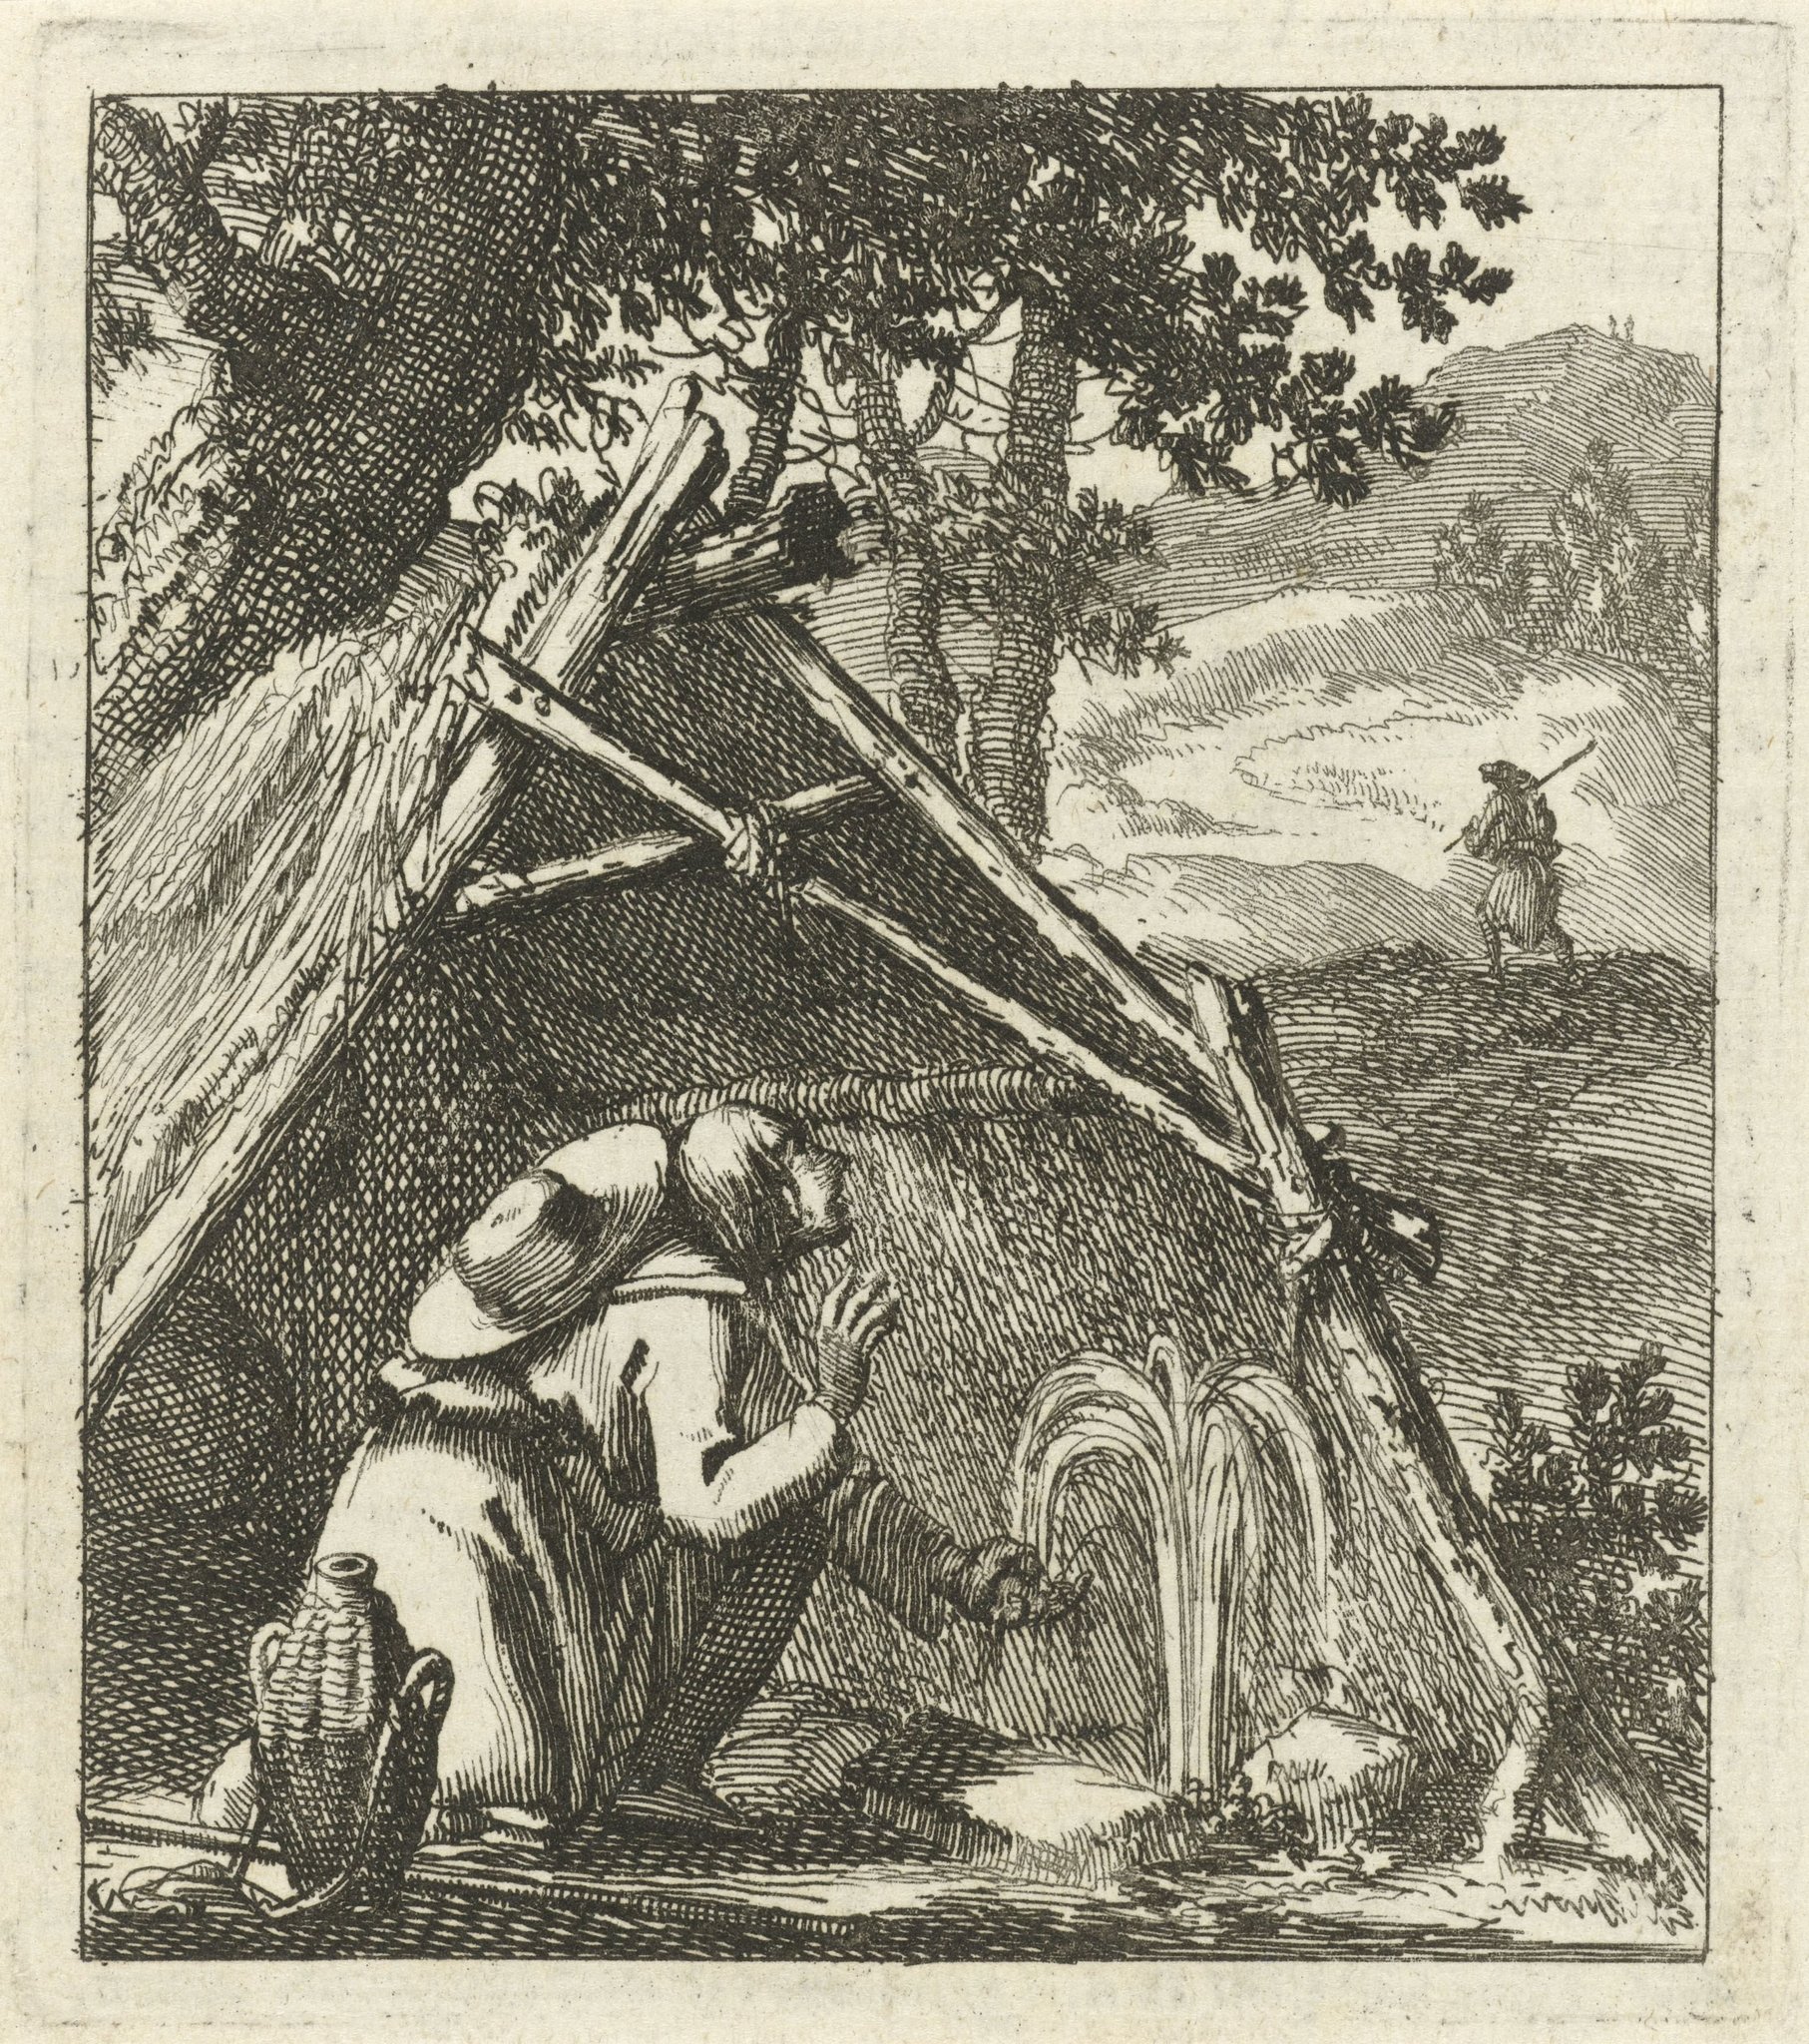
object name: print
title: Die enkel uit onkunde dwaald, Word van God weer te rug gehaald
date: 1689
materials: paper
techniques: etching, letterpress printing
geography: amsterdam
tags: pilgrimage, pilgrim(s) under way, spring (fluids extracted from the earth), hut, cabin, lodge, 'en route', traveller under way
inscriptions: collector's mark: Lugt 2228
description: Illustratie uit: Huygen, Pieter. De beginselen van Gods koninkryk in den mensch uitgedrukt in zinnebeelden. Amsterdam: wed. Arentsz. Pieter (II), 1689, p. 26.